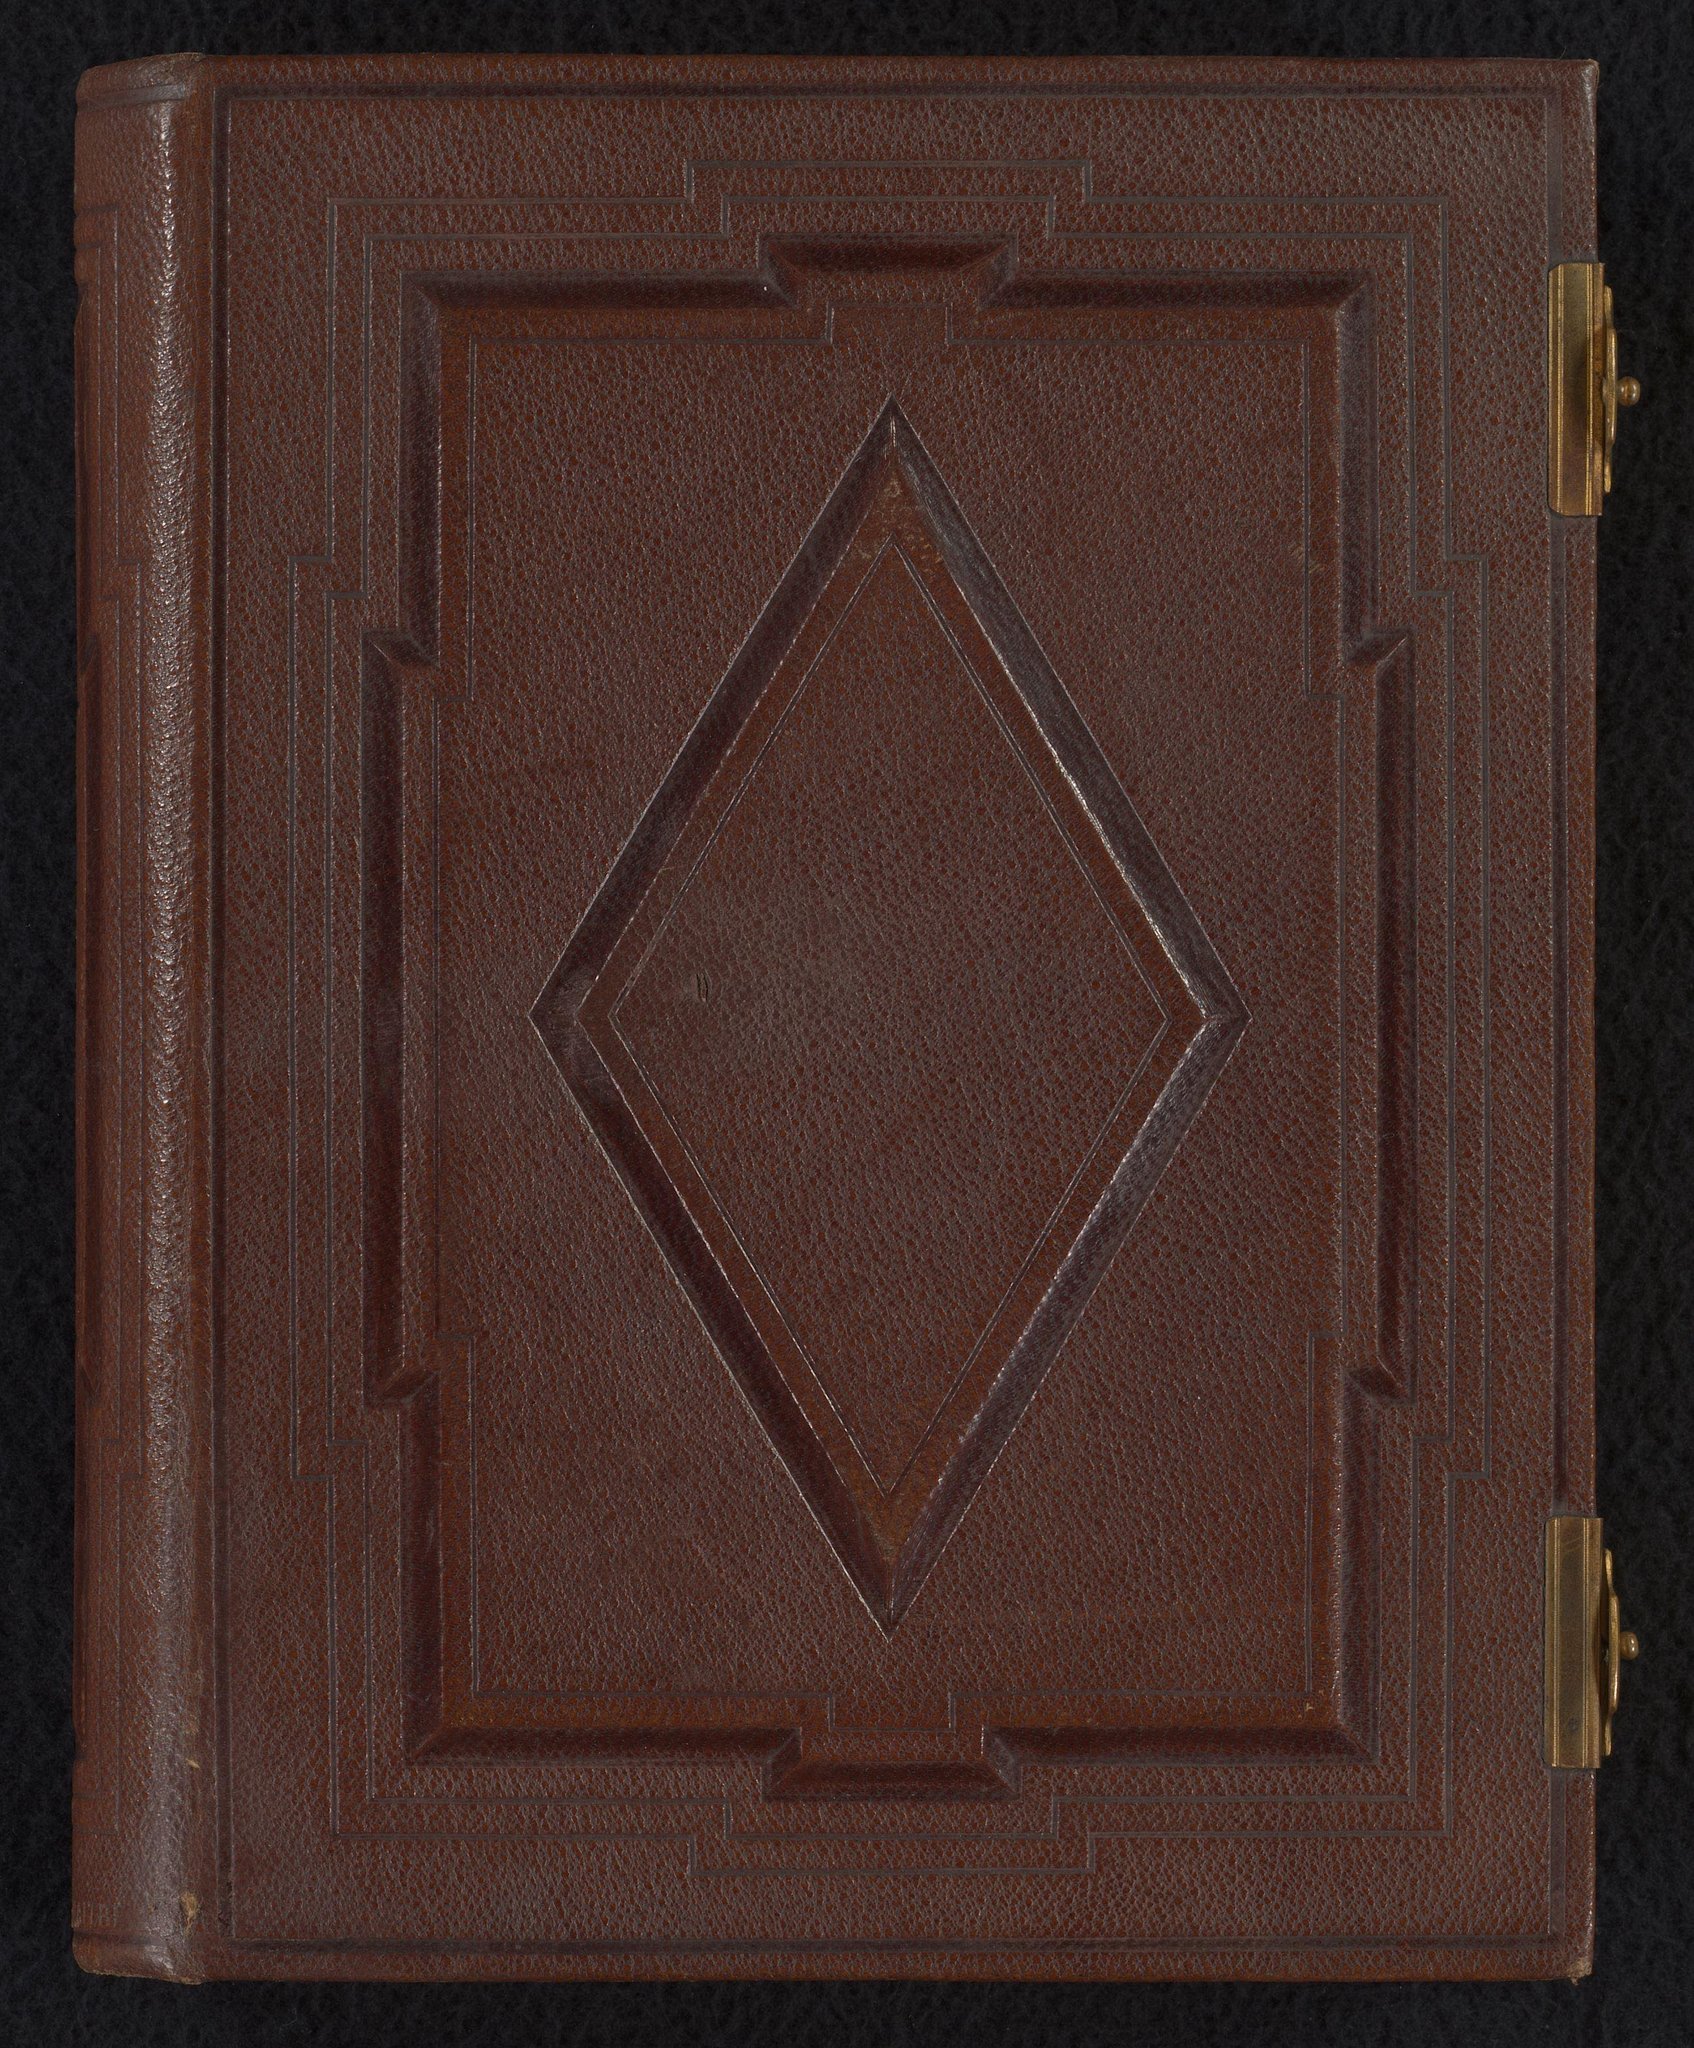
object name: photograph album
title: Fotoalbum (leeg)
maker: Anonymous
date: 1860-1900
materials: cardboard, leather, metal, paper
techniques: color on snow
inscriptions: collector's mark: ‘DIENST/ VERSPREIDE/ RIJKSKOLLEKTIES/ (...) A 862’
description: Fotoalbum met dertig pagina's met ieder een met gepreegde rand omkaderde passe-partout voor een kabinetfoto. Op de rug van het album is de naam Antoine Maitre gepreegd.